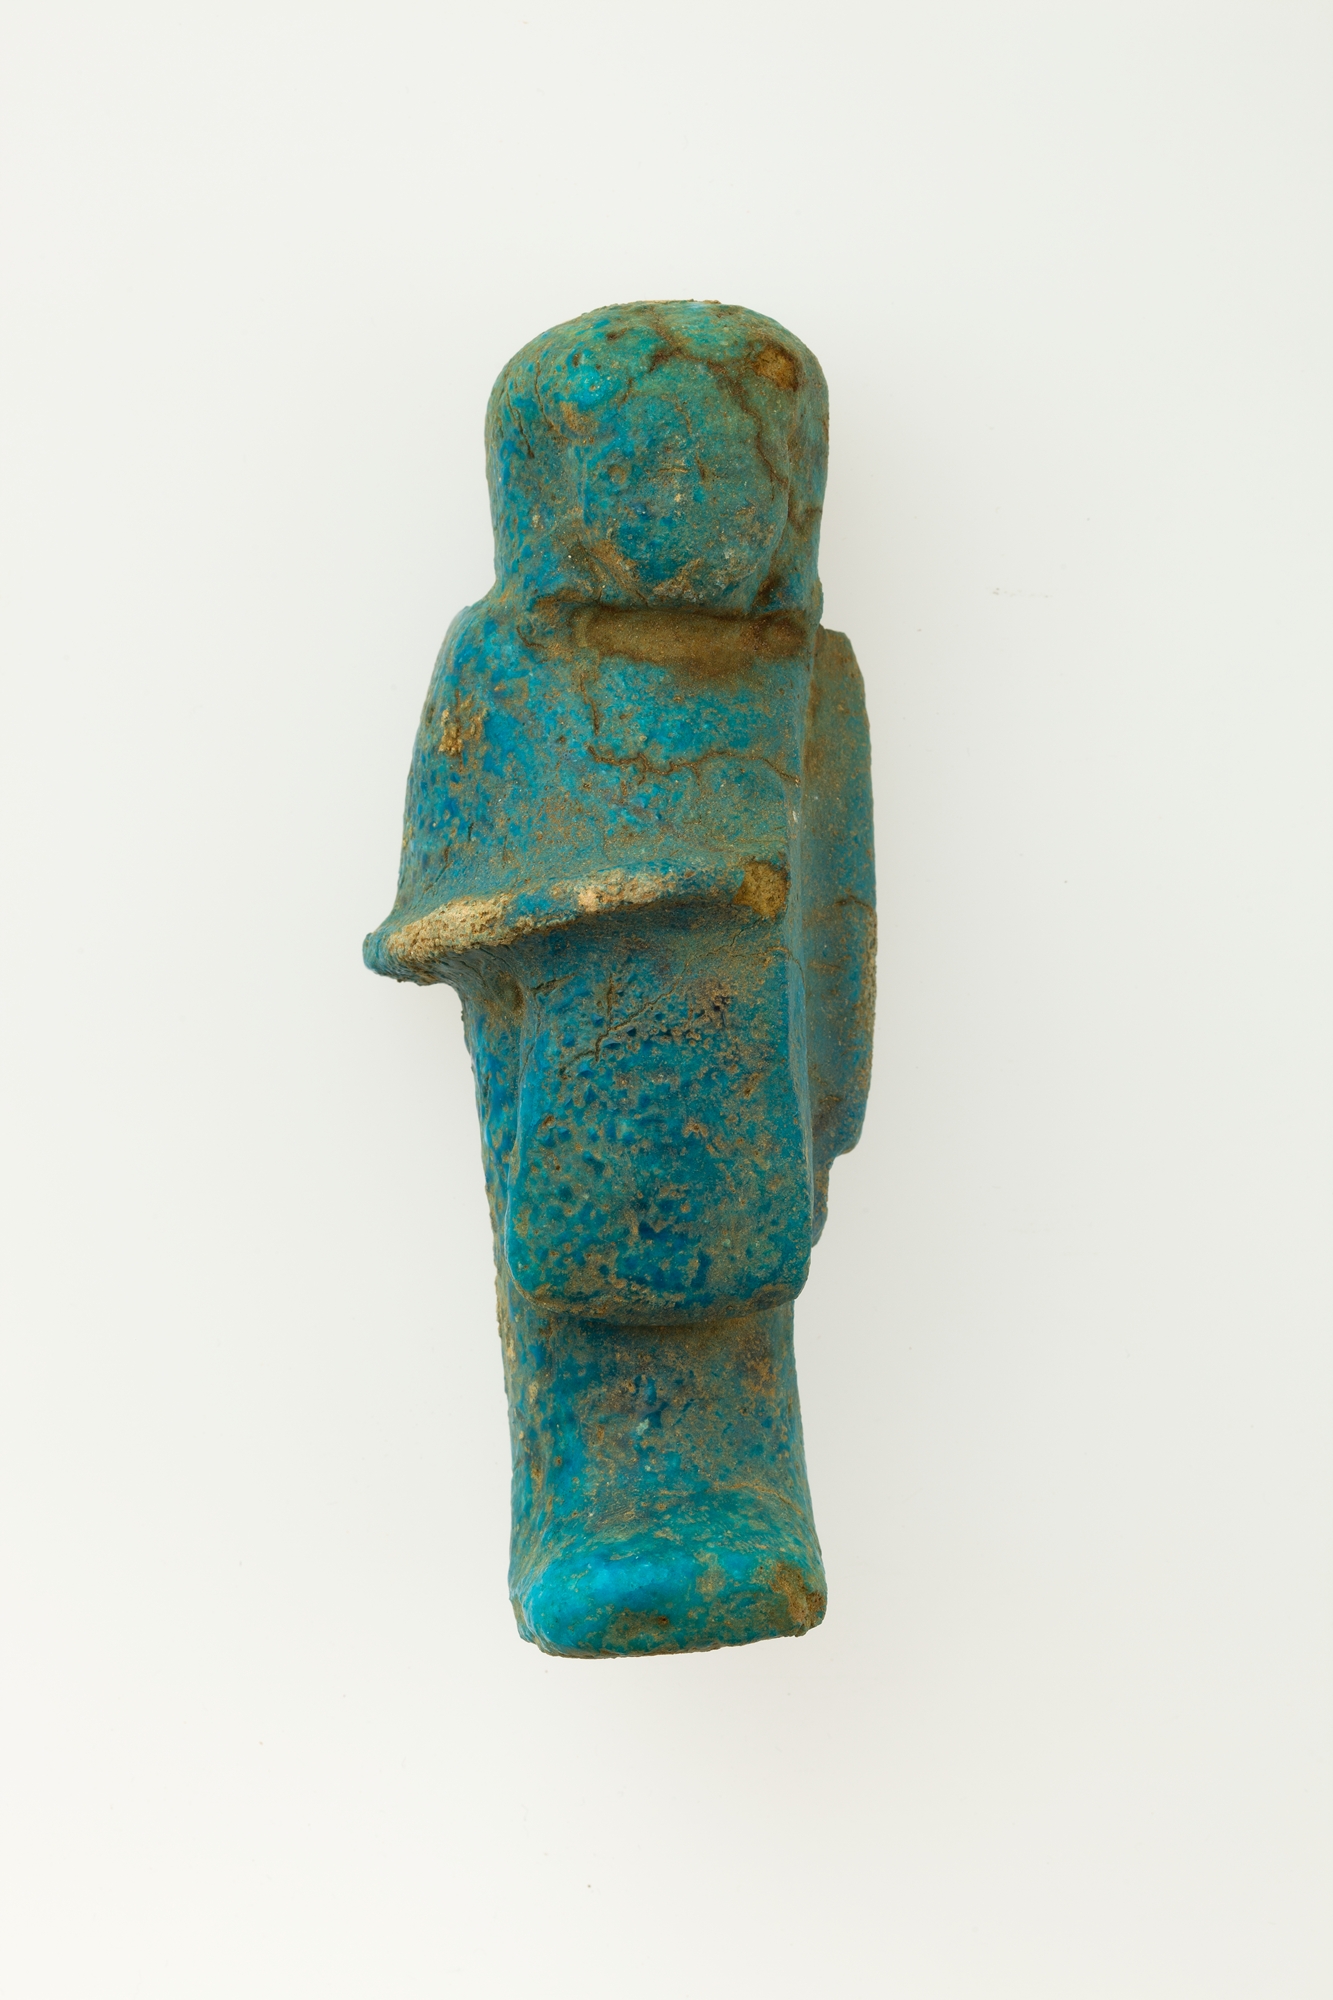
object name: shabti, henettawy c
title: Overseer Shabti of Henettawy (C), Daughter of Isetemkheb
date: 990-970 BCE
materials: faience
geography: egypt